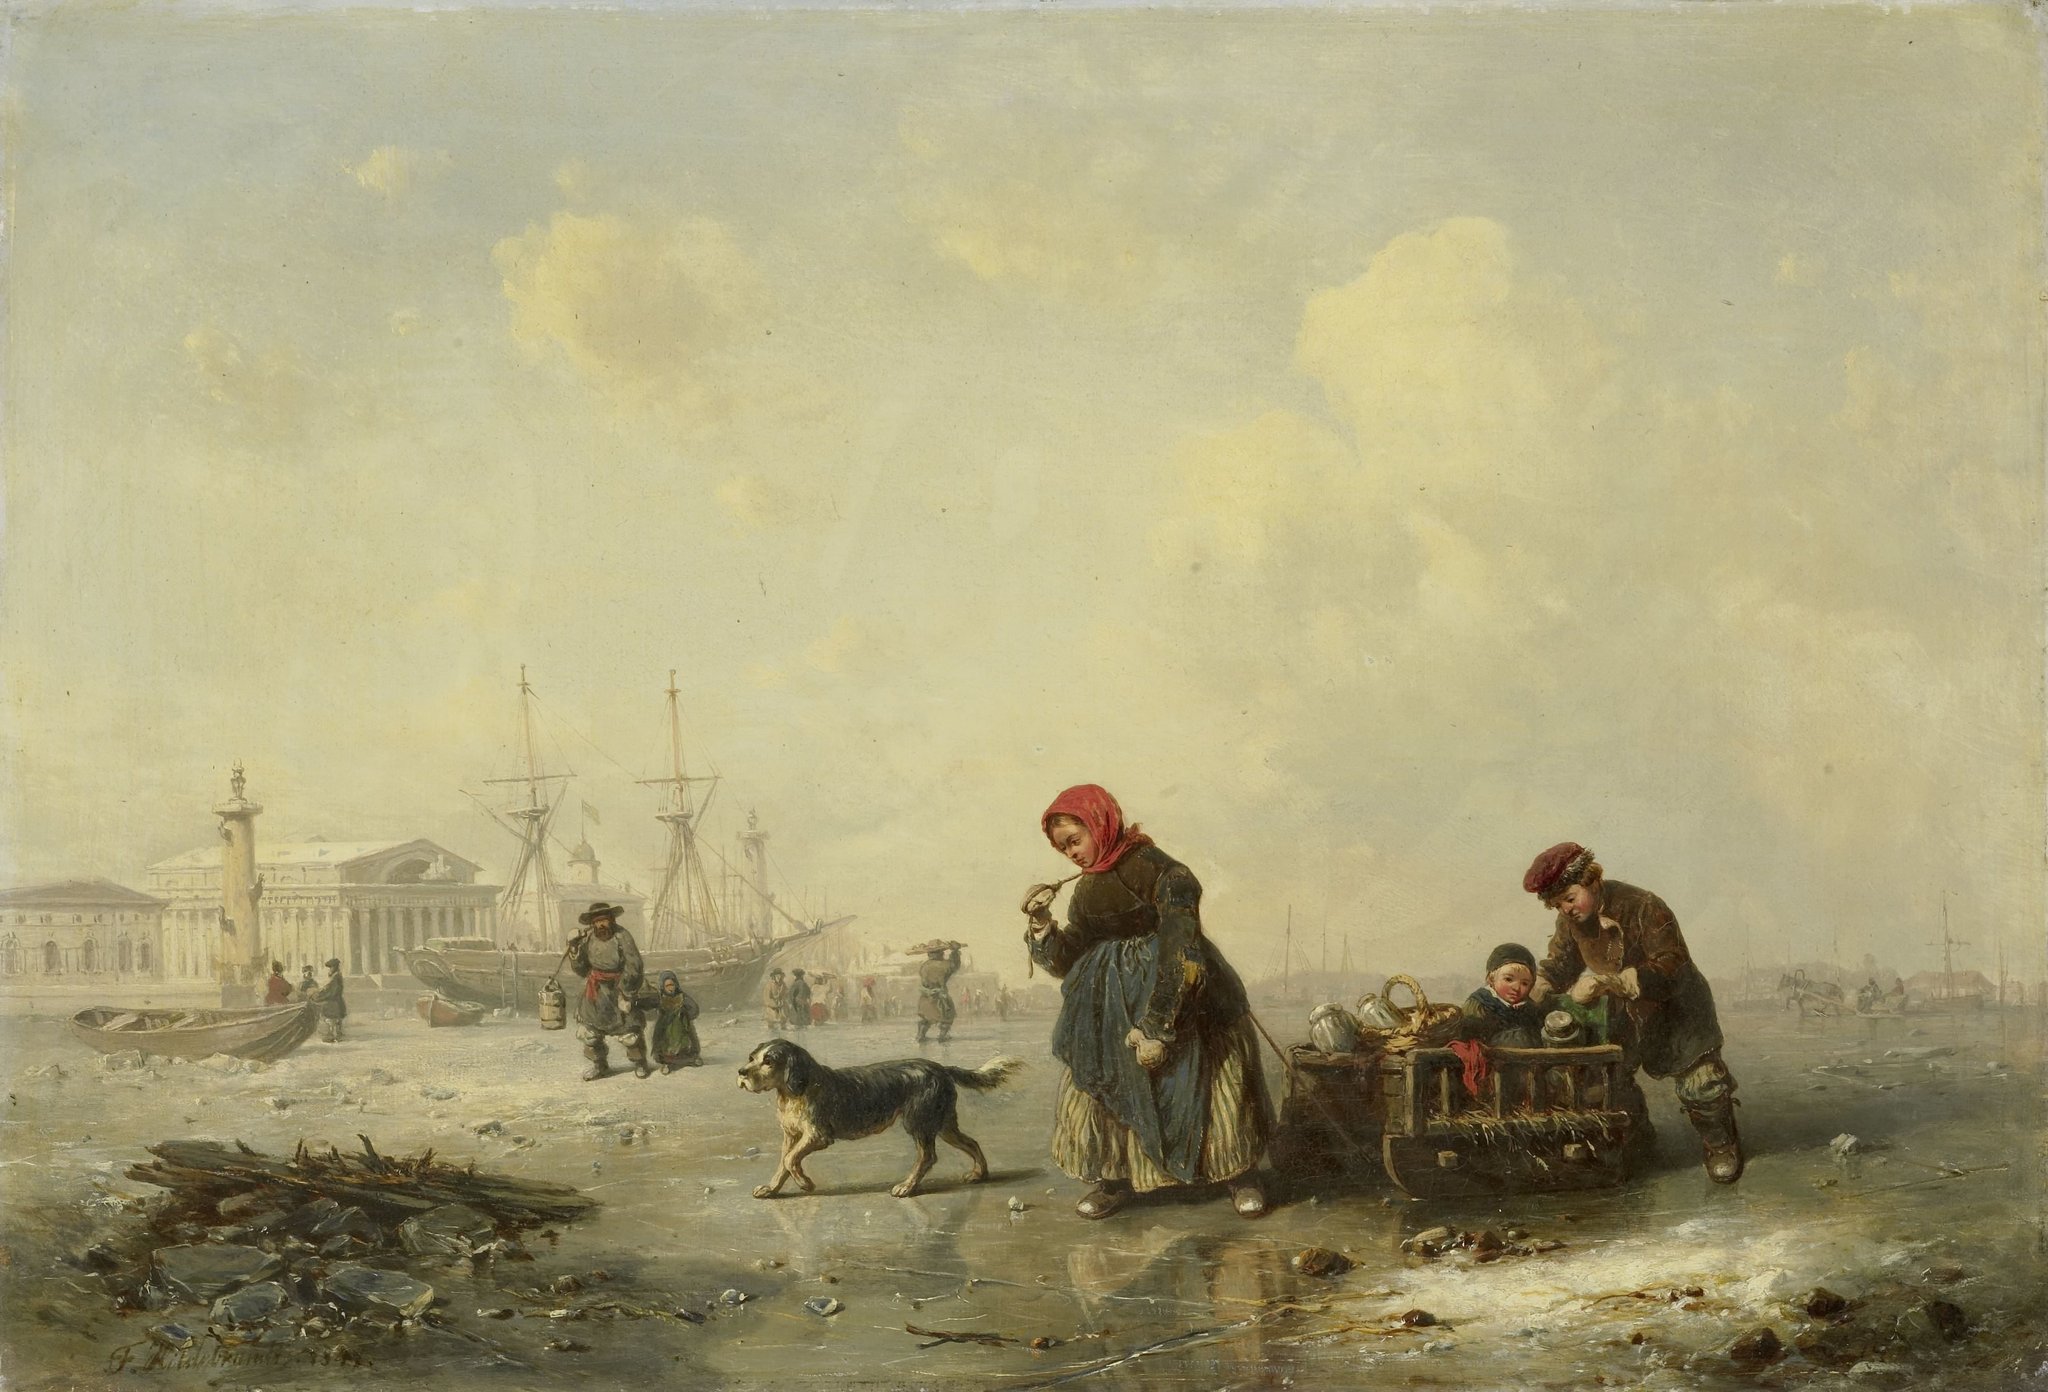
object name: painting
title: The Neva at St Petersburg (Leningrad) in the Winter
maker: theodor hildebrandt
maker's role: draughtsman, painter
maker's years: 1804-1874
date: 1844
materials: canvas, oil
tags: sleigh, sledge (non-sport), ice ~ freezing weather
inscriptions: signature and date: ‘Th. Hildebrand 1844’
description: De bevroren rivier de Neva bij Sint Petersburg (Leningrad) in de winter. Een vader en moeder trekken een slede, waarin een kind zit, over het ijs, links een hond. Links op de achtergrond regeringsgebouwen en een ingevroren zeilschip.